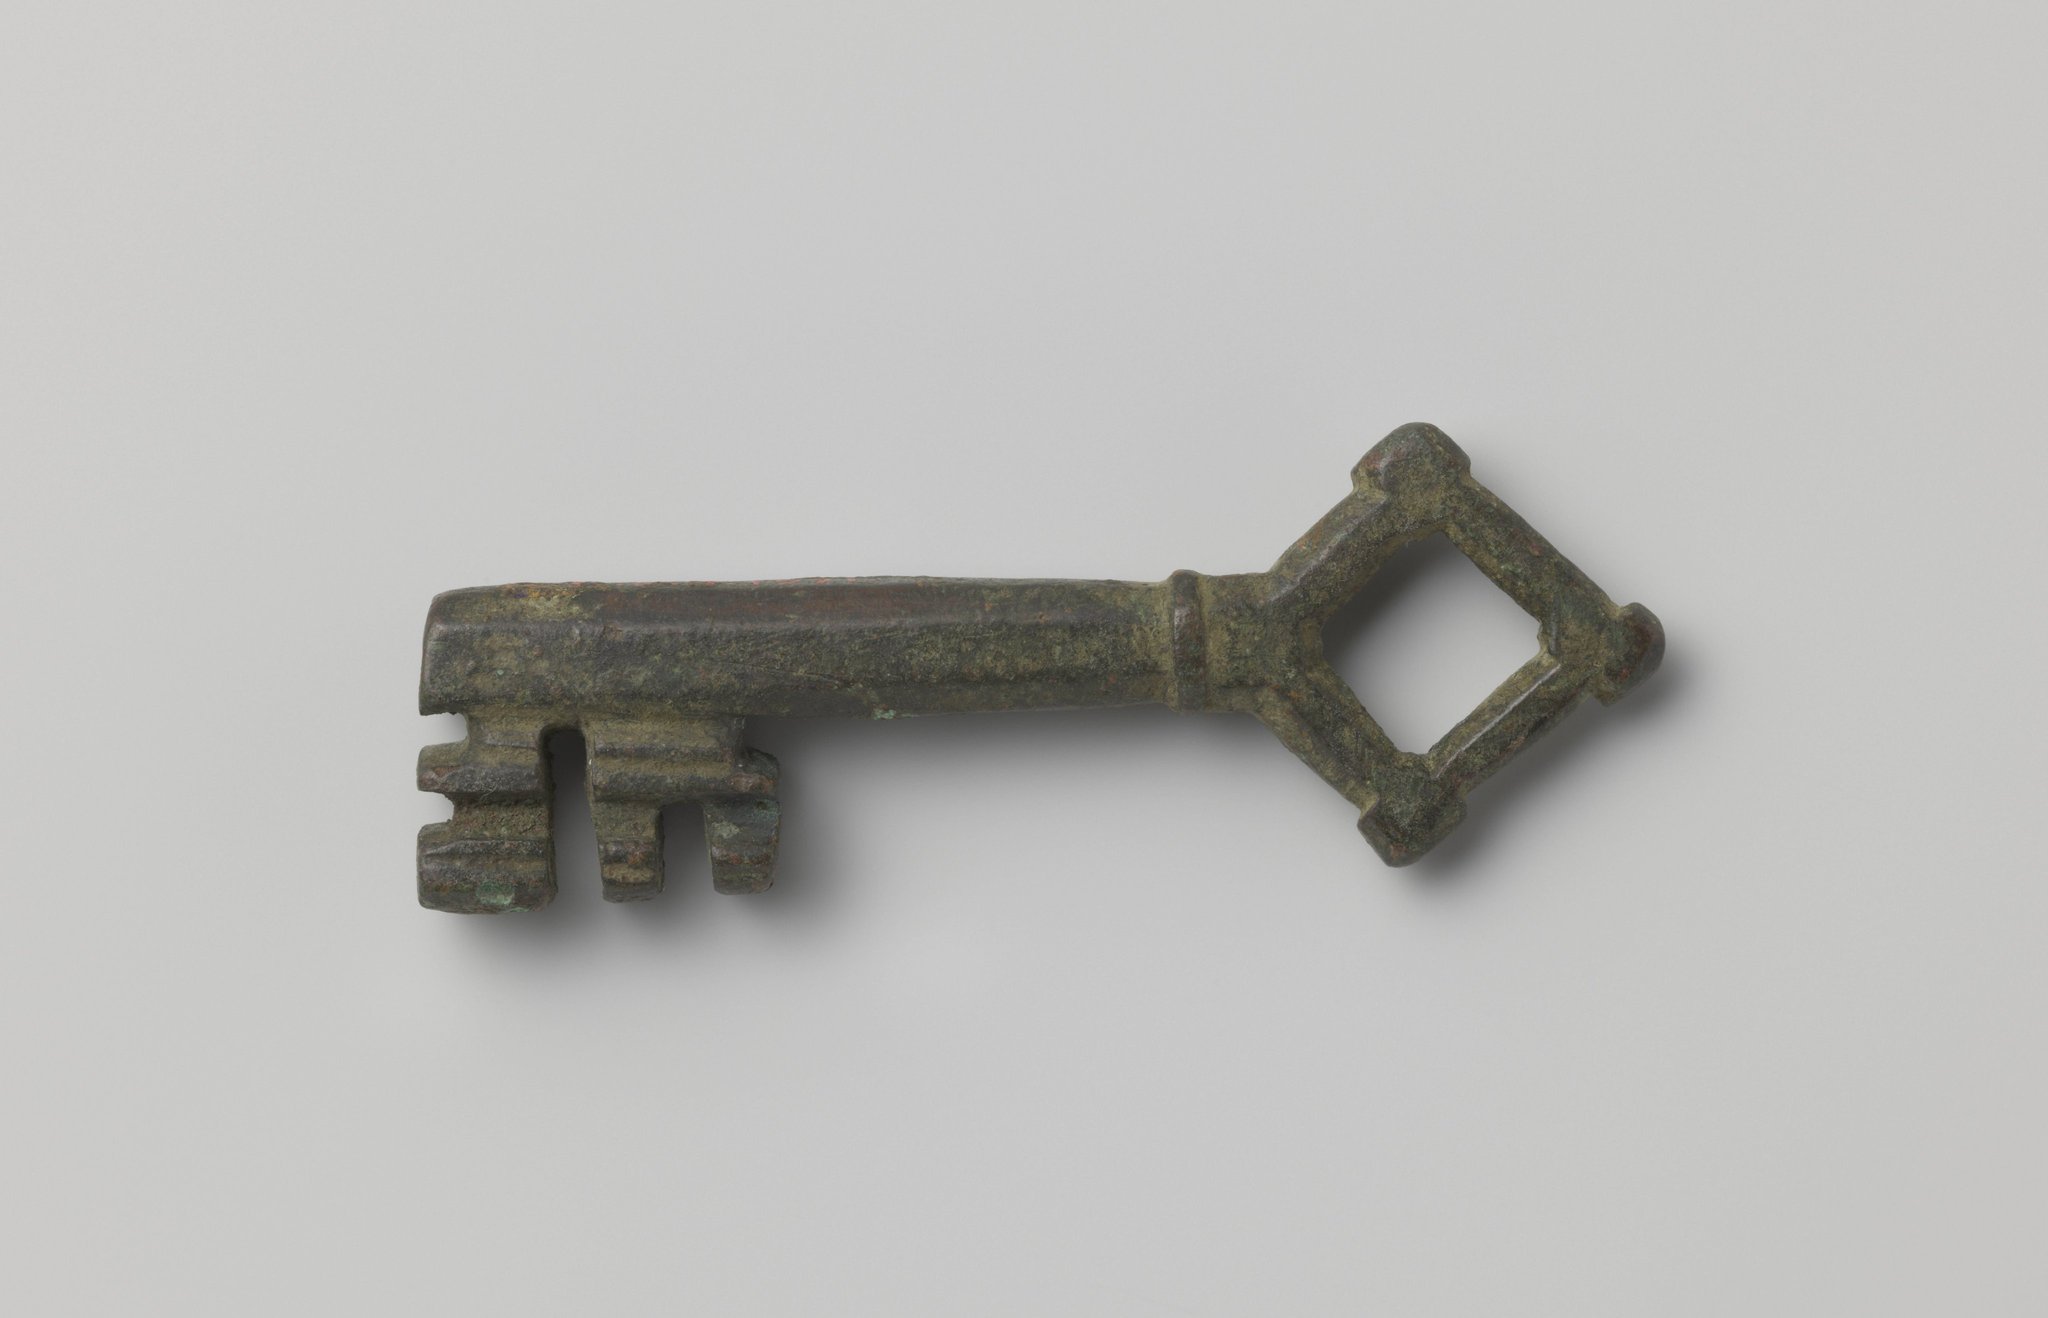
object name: pipe key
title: 39 keys from the collection of Emmanuel Vita Israël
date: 1200-1300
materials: bronze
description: The Amsterdam apothecary and art collector Emmanuel Vita Israël. He donated his collection, comprising keys dating from Roman antiquity to the 19th century, to the Koninklijk Oudheidkundig Genootschap (Royal Antiquarian Society) in 1937. Vita Israël claimed that his key collection had grown more or less by accident: being one of the few collectors of keys, dealers automatically made their way to him.